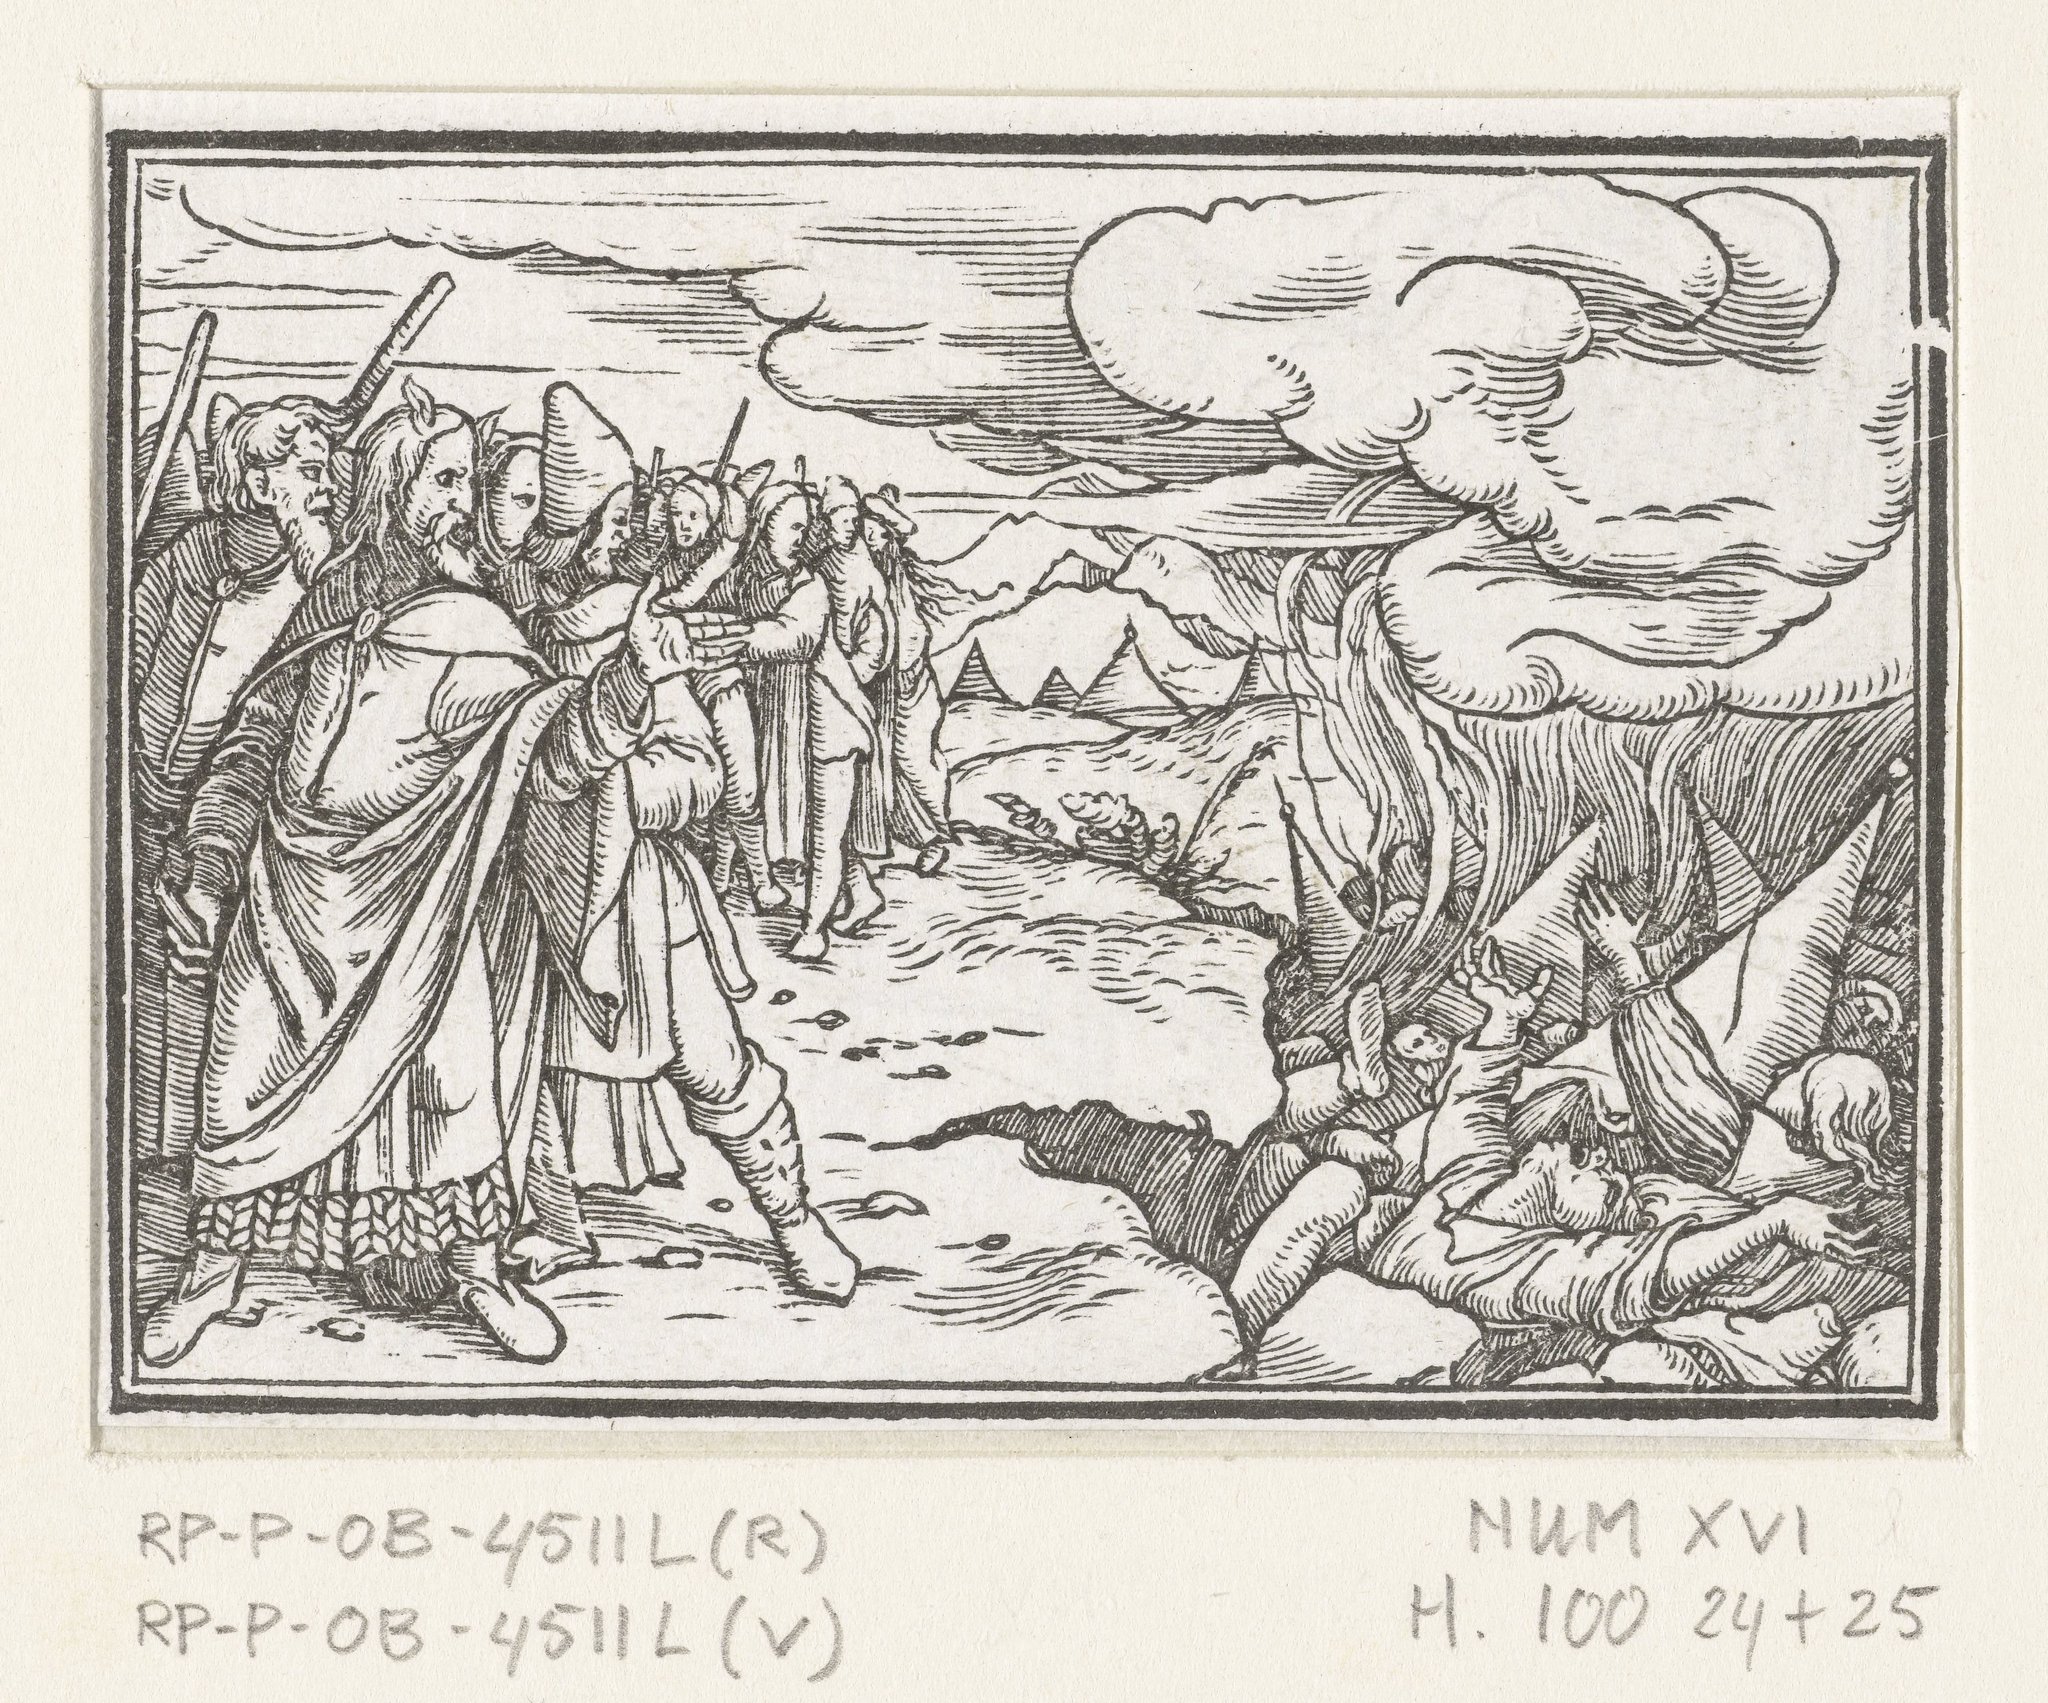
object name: print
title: Vernietiging van de stam van Korach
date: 1538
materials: paper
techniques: woodcut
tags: rebellion of korah (core), dathan and abiram, and their punishment (numbers 16)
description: Houtblok voor het eerst gebruikt in: Biblia Utriusque Testamenti iuxta Vulgatam Translationem, Lyon, M. en G. Trechsel (voor Hugo à Porta) 1538. Later in verschillende uitgaven opnieuw gebruikt.